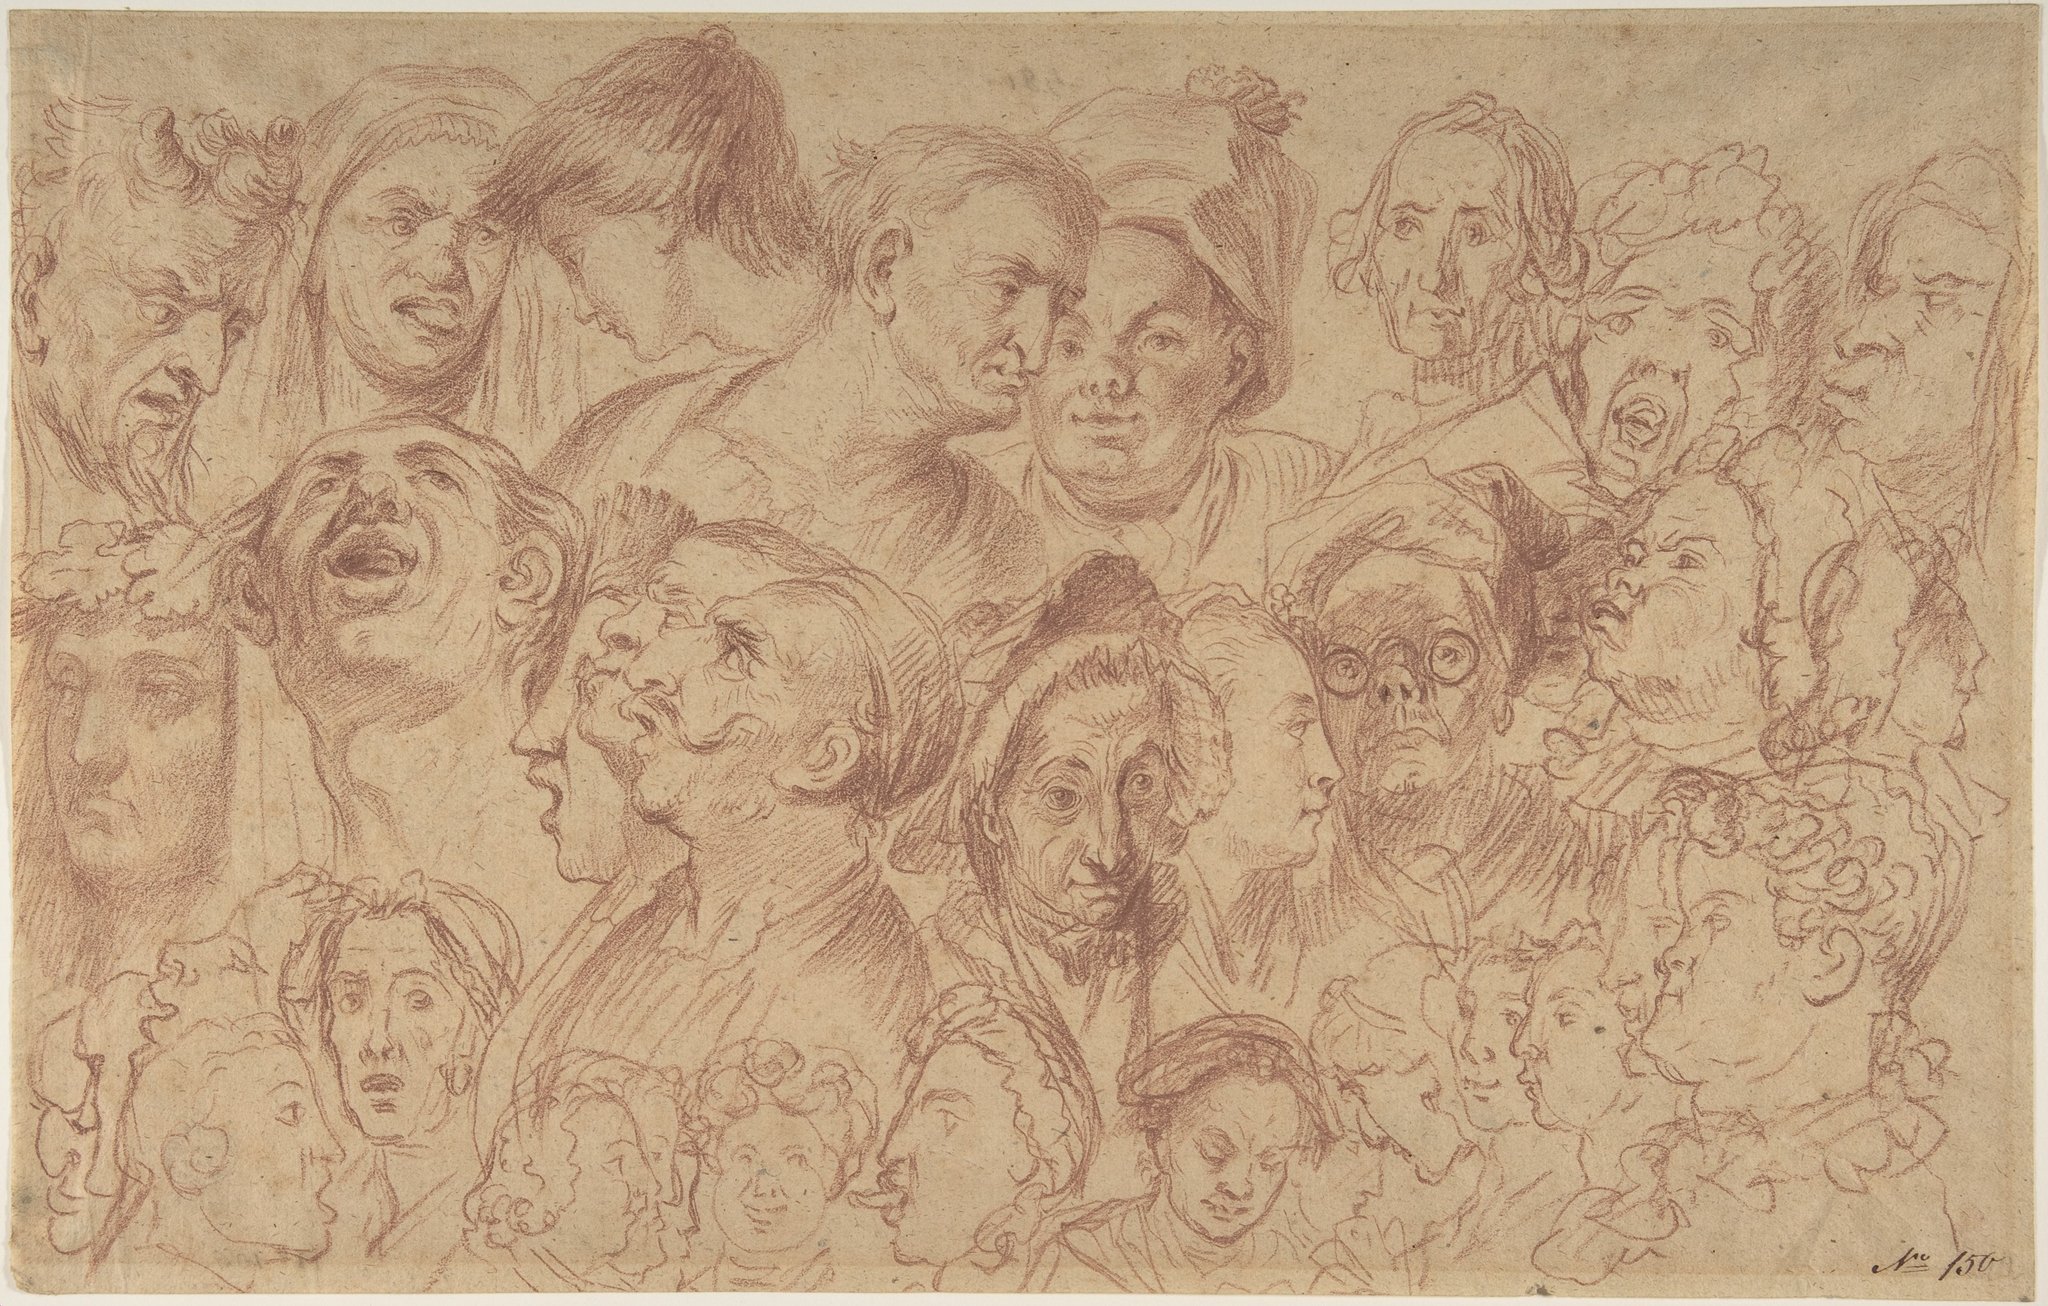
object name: drawing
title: Sheet of Studies of Heads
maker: william hogarth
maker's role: artist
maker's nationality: british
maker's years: 1697-1764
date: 1795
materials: chalk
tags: heads,men,women